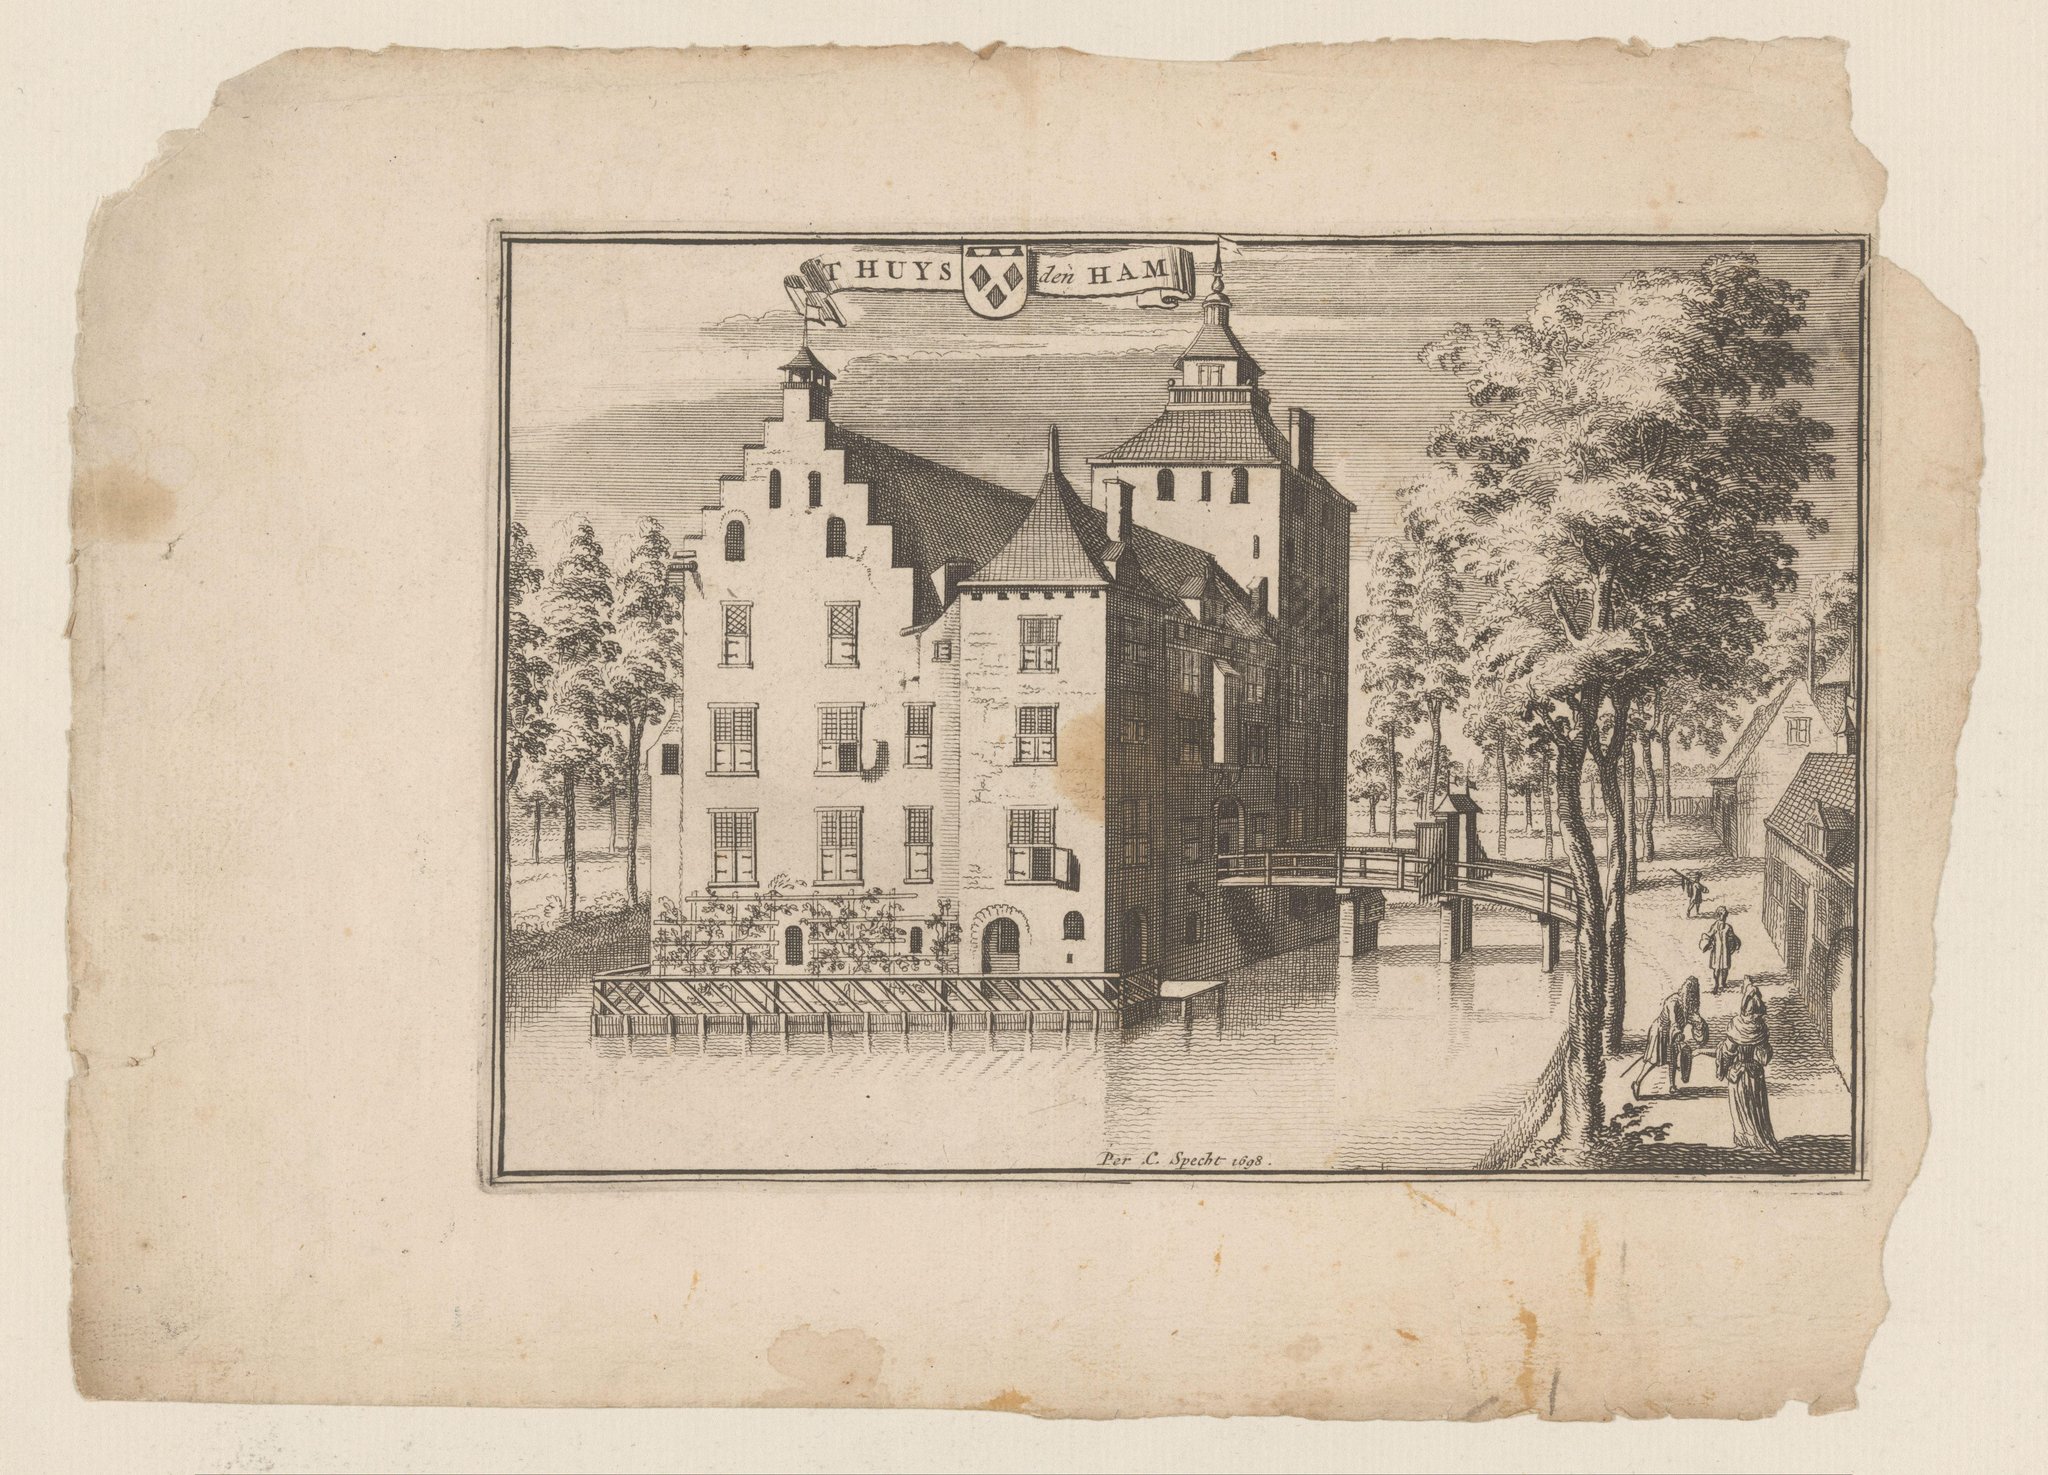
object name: print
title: 't Huys den Ham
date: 1698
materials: paper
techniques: engraving, etching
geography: utrecht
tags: castle, landscape with tower or castle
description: Prent uit: De Ridder-matige Huysen en Gesichten in de Provincie van Utrecht. Utrecht: Caspar Specht, 1698.